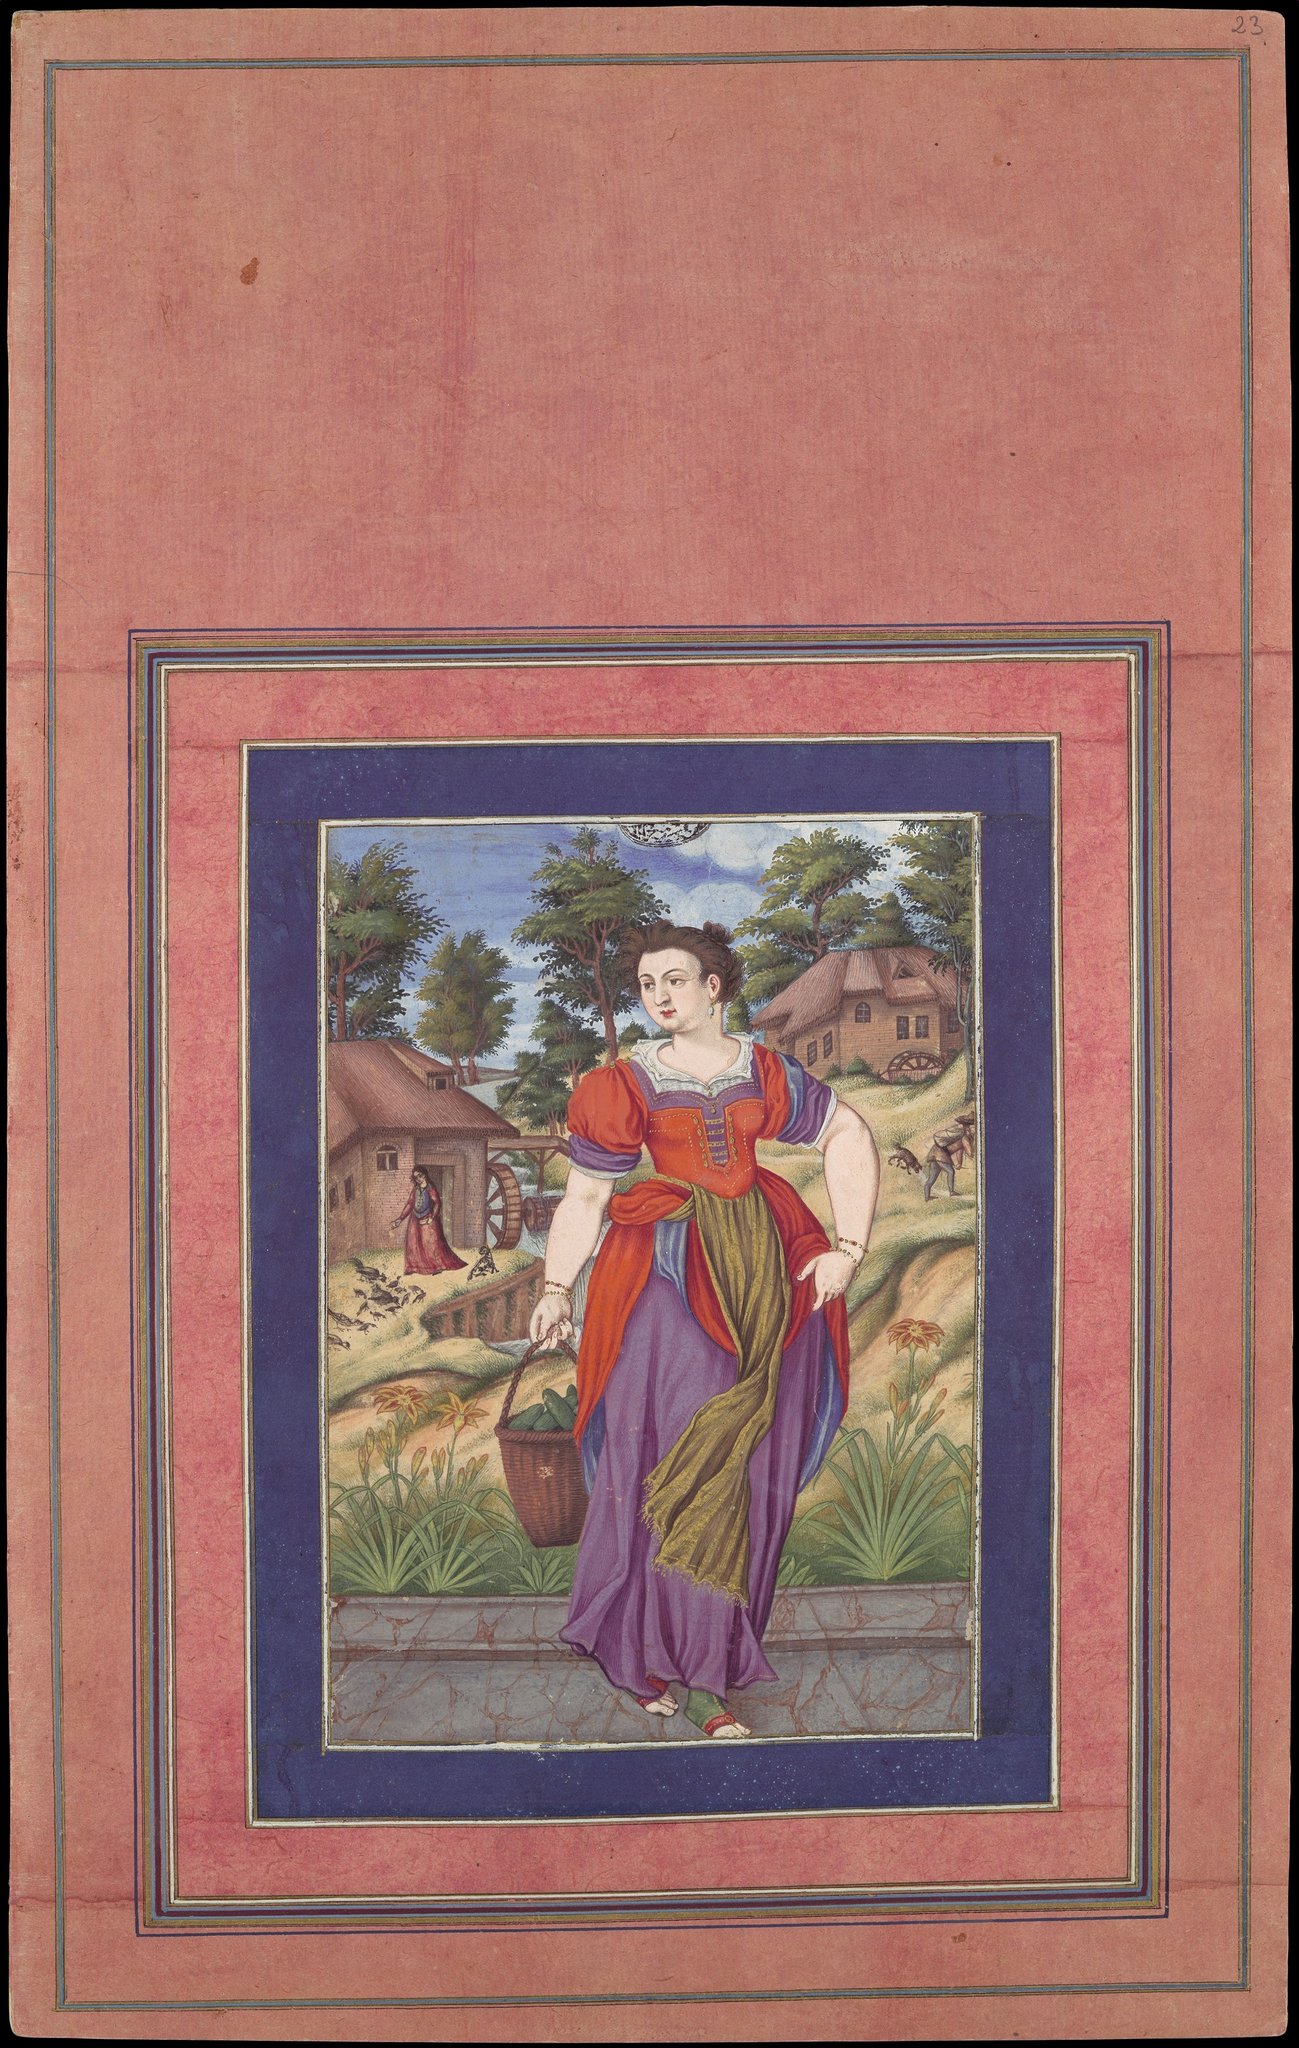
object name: illustrated album leaf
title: "Summer, from a Series of the Four Seasons", Folio from the Davis Album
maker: 'ali quli jabbadar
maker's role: artist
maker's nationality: iranian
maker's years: 1620-1699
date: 1660-1670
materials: gold, ink, paper, watercolor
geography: iran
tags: houses,women,trees